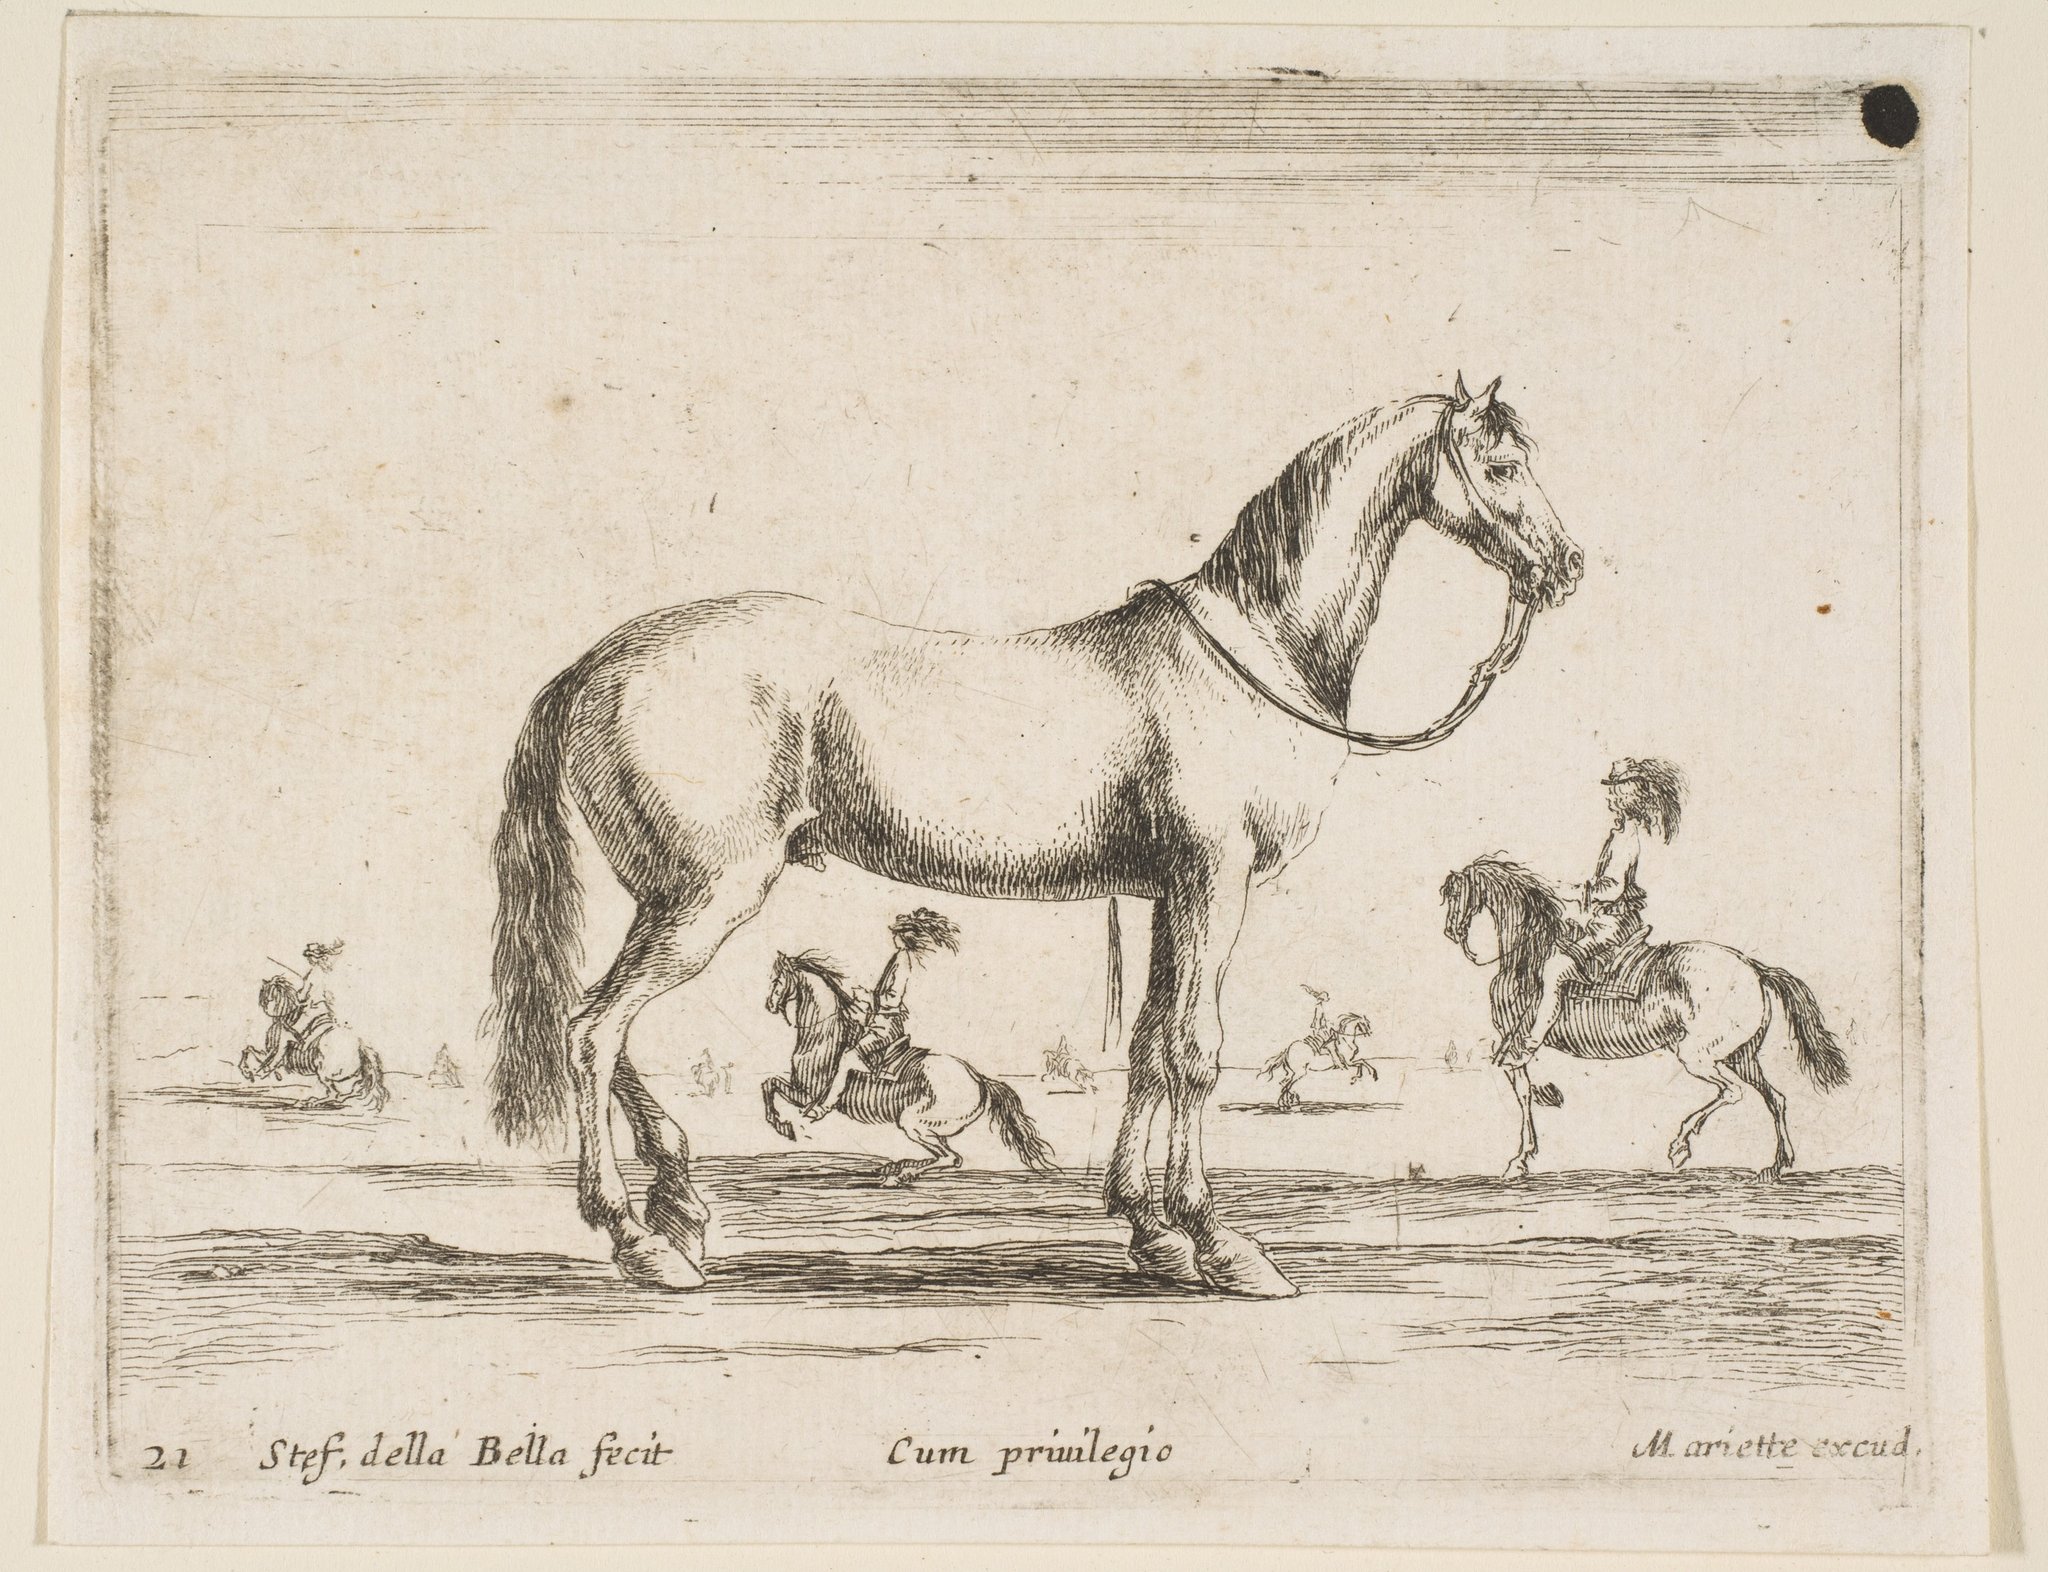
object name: print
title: Horse, plate 21 from "Various Animals" (Diversi Animali)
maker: stefano della bella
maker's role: artist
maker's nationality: italian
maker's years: 1610-1664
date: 1641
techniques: etching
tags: men,horses